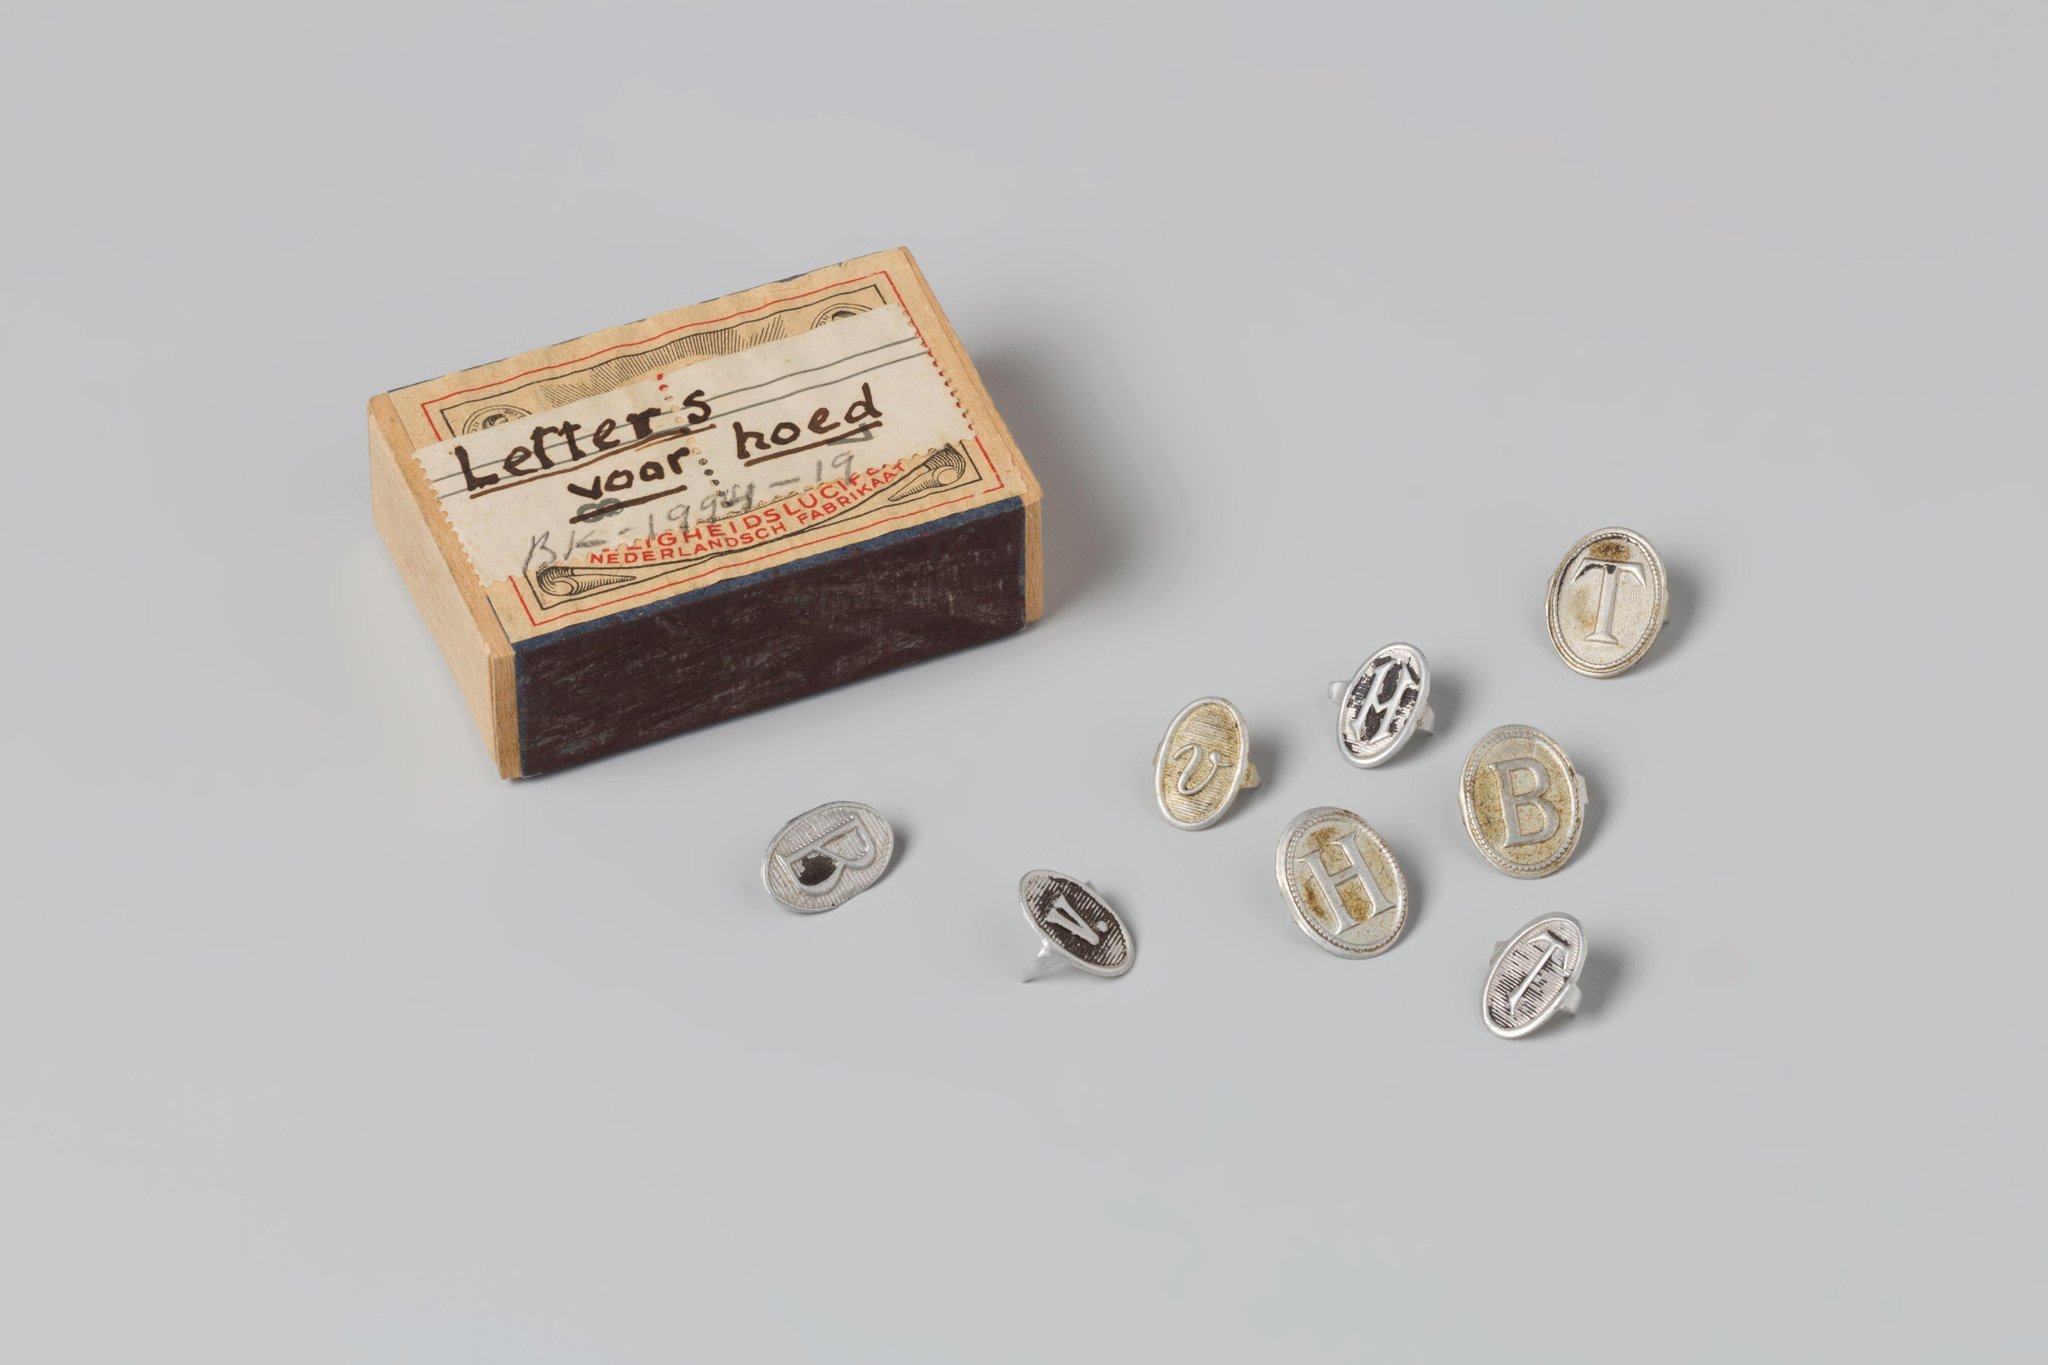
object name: insignia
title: Letters van blik om in een hoedrand te klemmen, acht stuks in een luciferdoosje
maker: Anonymous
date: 1900-1950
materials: cardboard, paper, metal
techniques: striking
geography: netherlands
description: Letters van blik om in een hoedrand te klemmen, acht stuks in een luciferdoosje (H, H, T, T, V, V, B, B).